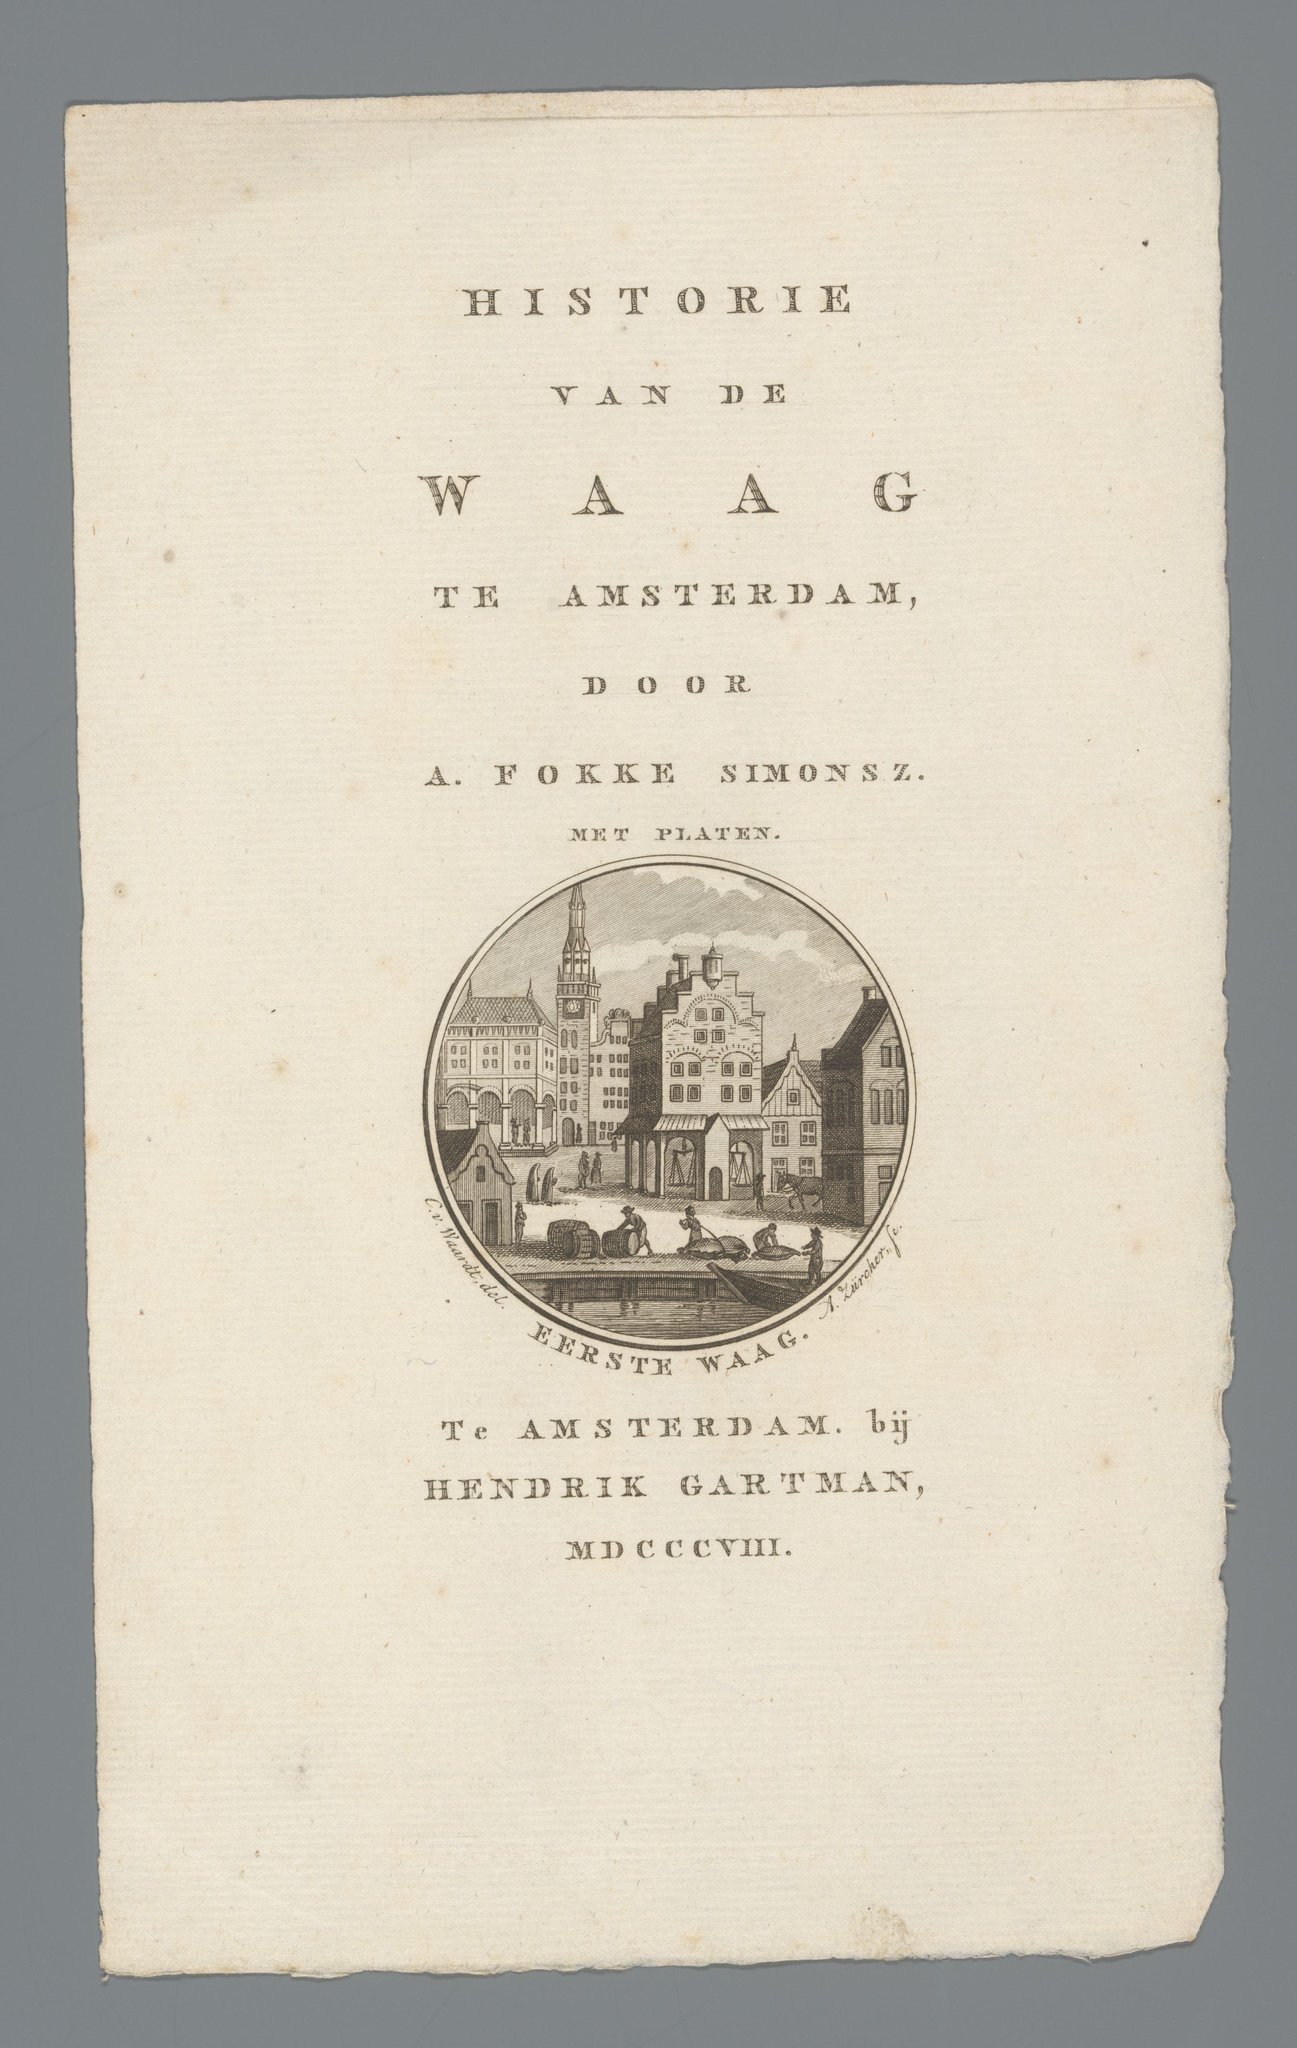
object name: print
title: Titelpagina voor: Fokke, Arend, Historie van de Waag te Amsterdam, 1808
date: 1808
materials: paper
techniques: engraving, etching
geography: amsterdam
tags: weigh-house, square, place, circus, etc. (+ city(-scape) with figures, staffage)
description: Titelpagina voor: Fokke, Arend. Historie van de Waag te Amsterdam. Amsterdam: Hendrik Gartman, 1808.